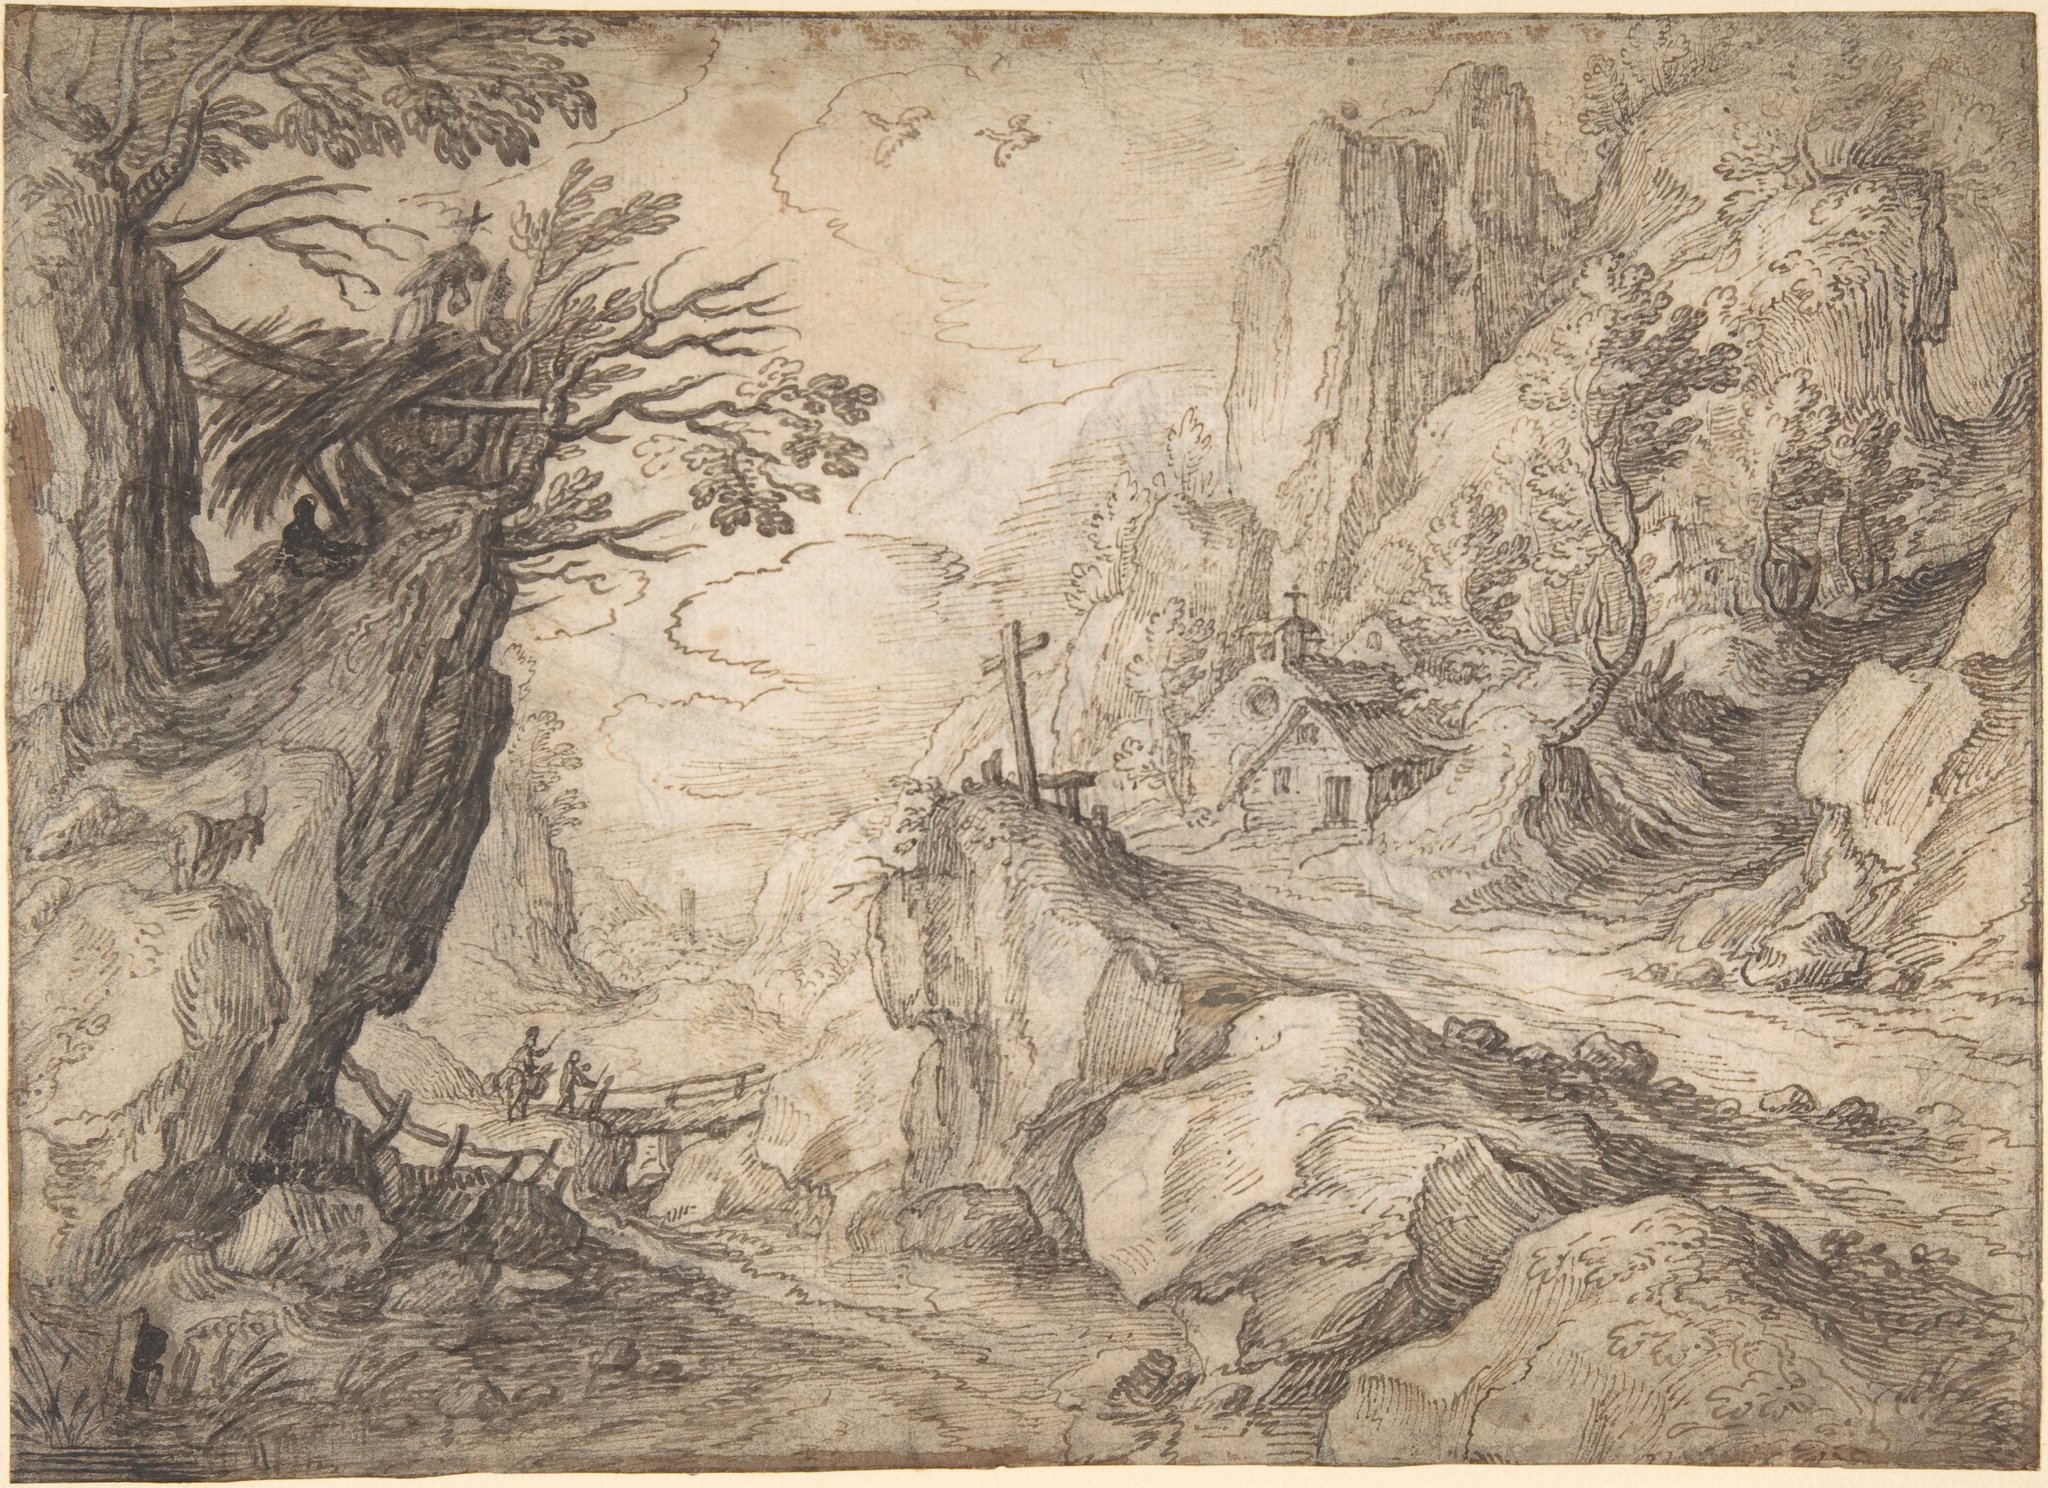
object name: drawing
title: A Mountainous River Landscape with a Hermit and a Chapel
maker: matthijs bril the younger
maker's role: artist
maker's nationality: netherlandish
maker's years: 1550-1583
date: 1570-1583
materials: chalk, ink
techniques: pen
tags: rivers,landscapes,cross